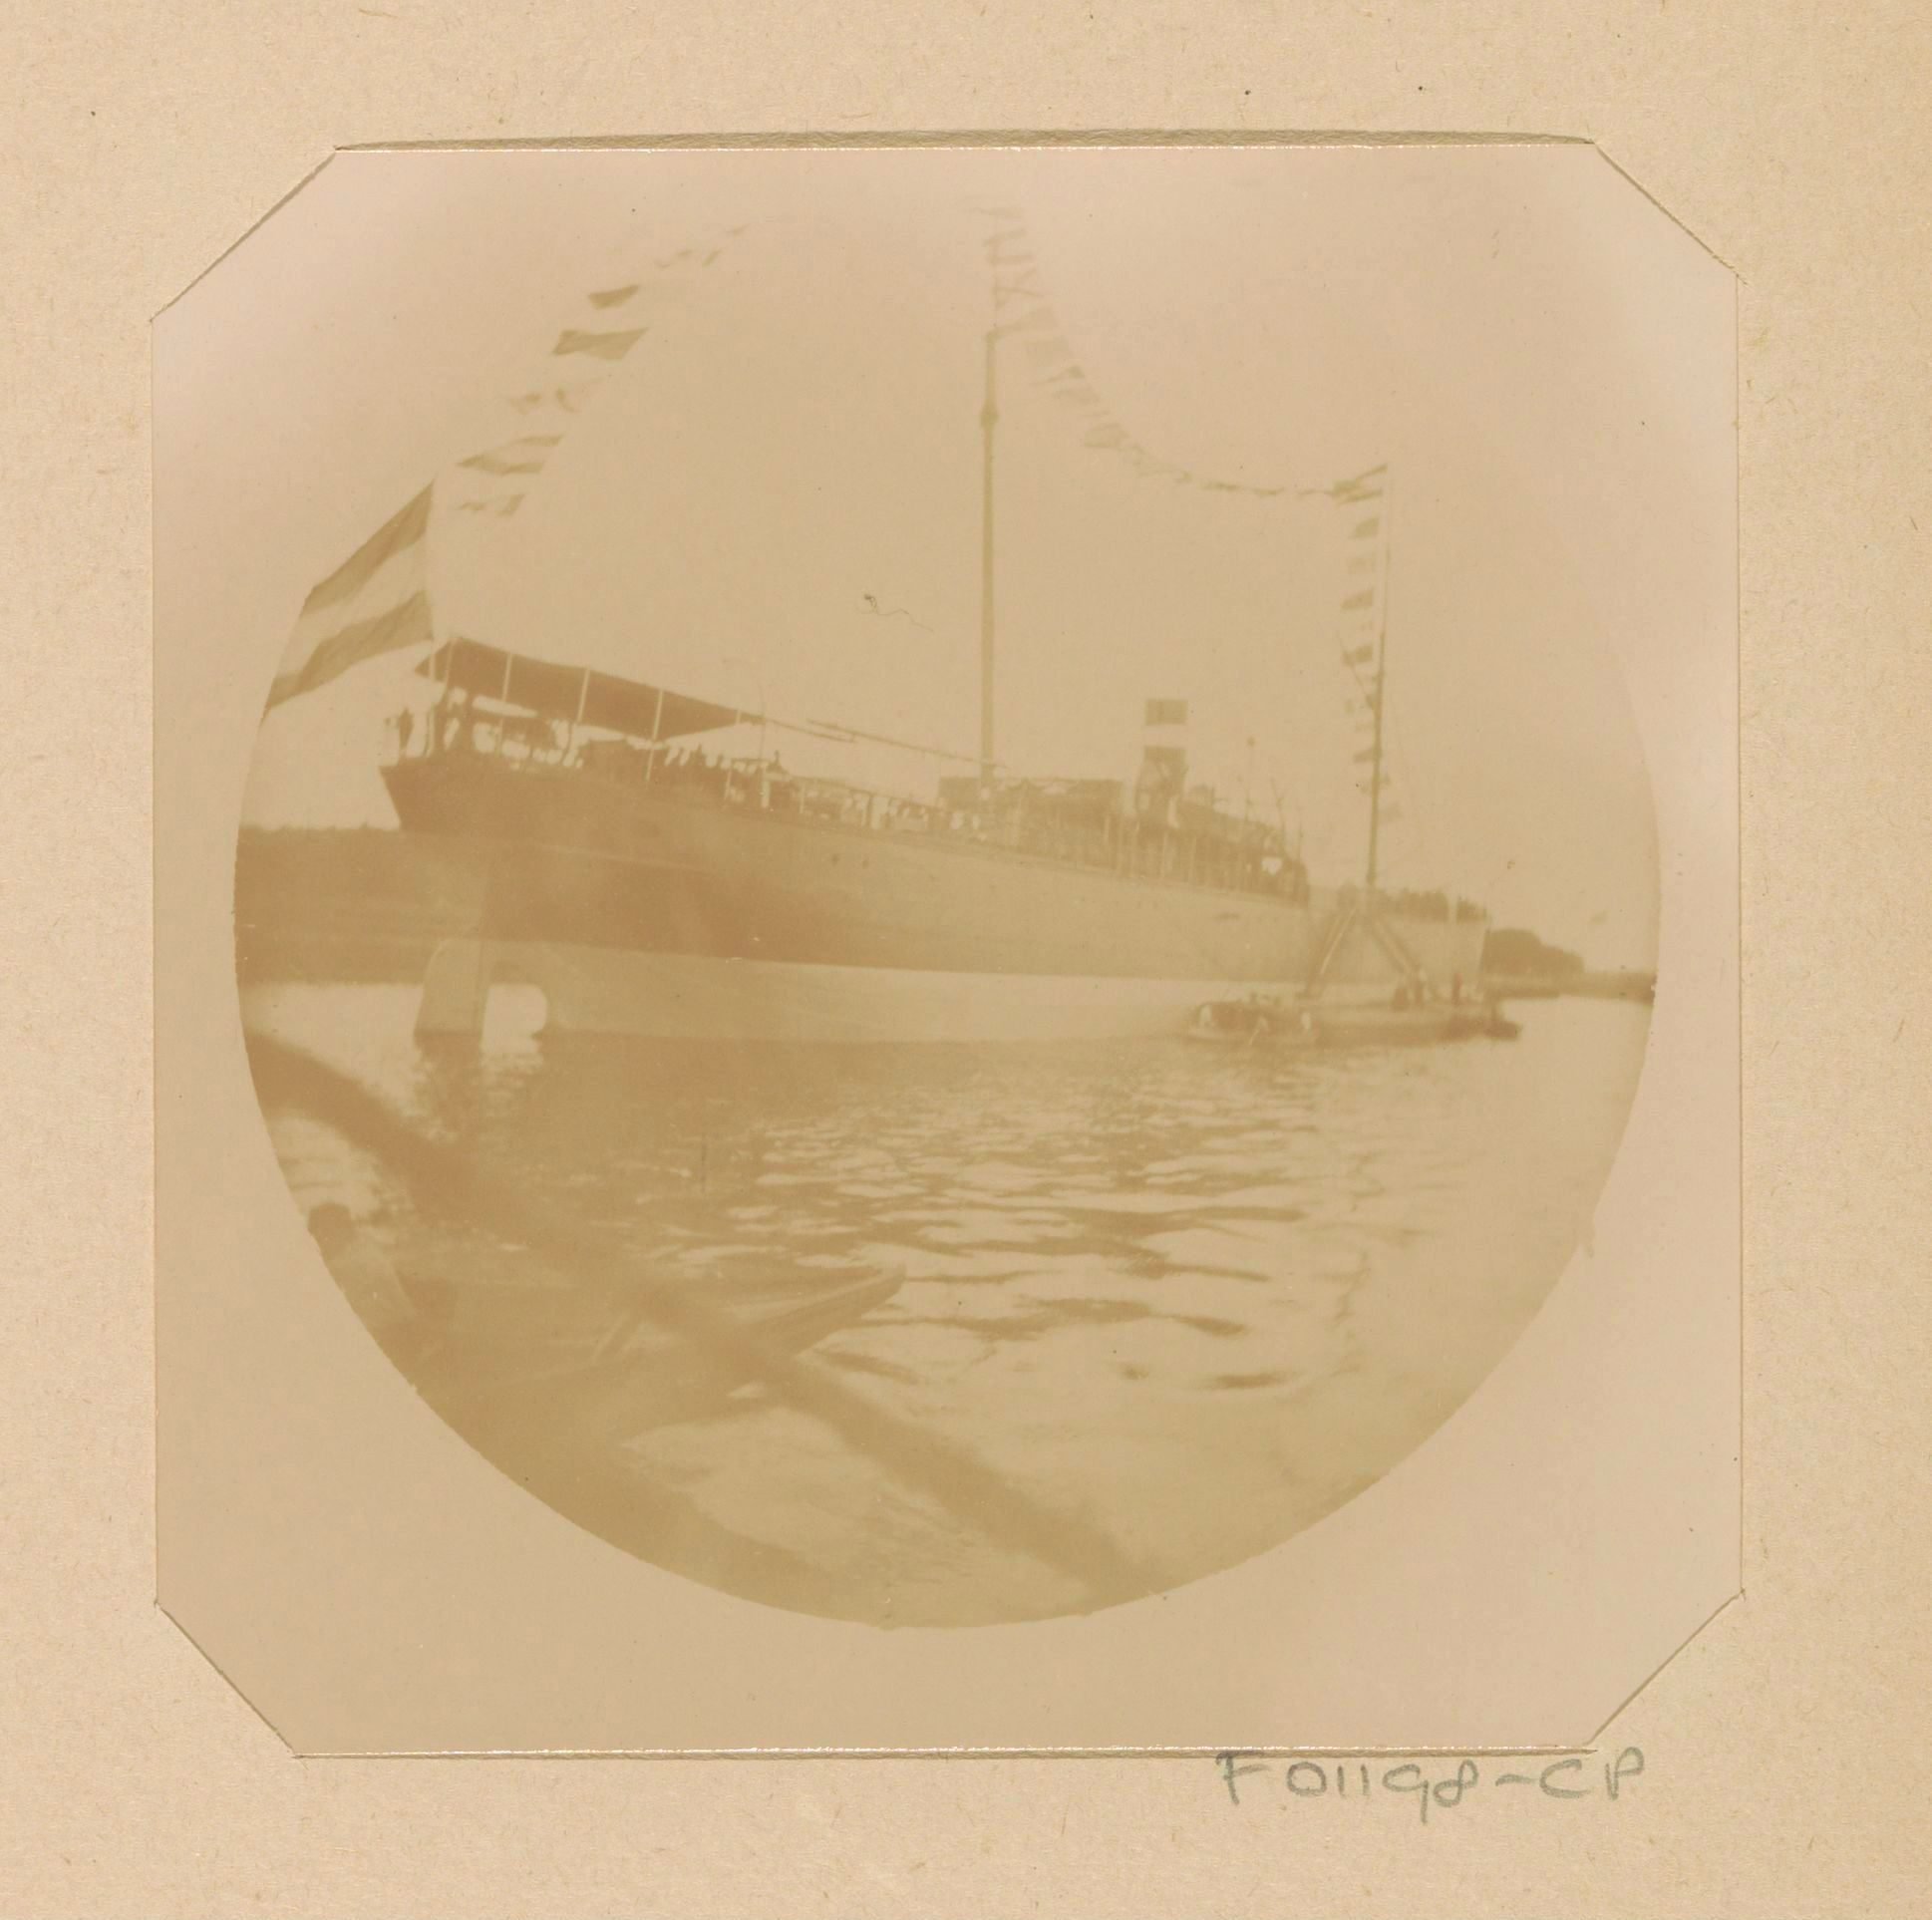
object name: photograph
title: Versierd schip op het IJ tijdens de Keizersfeesten in Amsterdam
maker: johanna margaretha piek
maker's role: fotograaf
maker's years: 1870-1947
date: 1891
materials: paper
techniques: gelatin silver print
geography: amsterdam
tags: ships (in general), imperial celebrations 1891